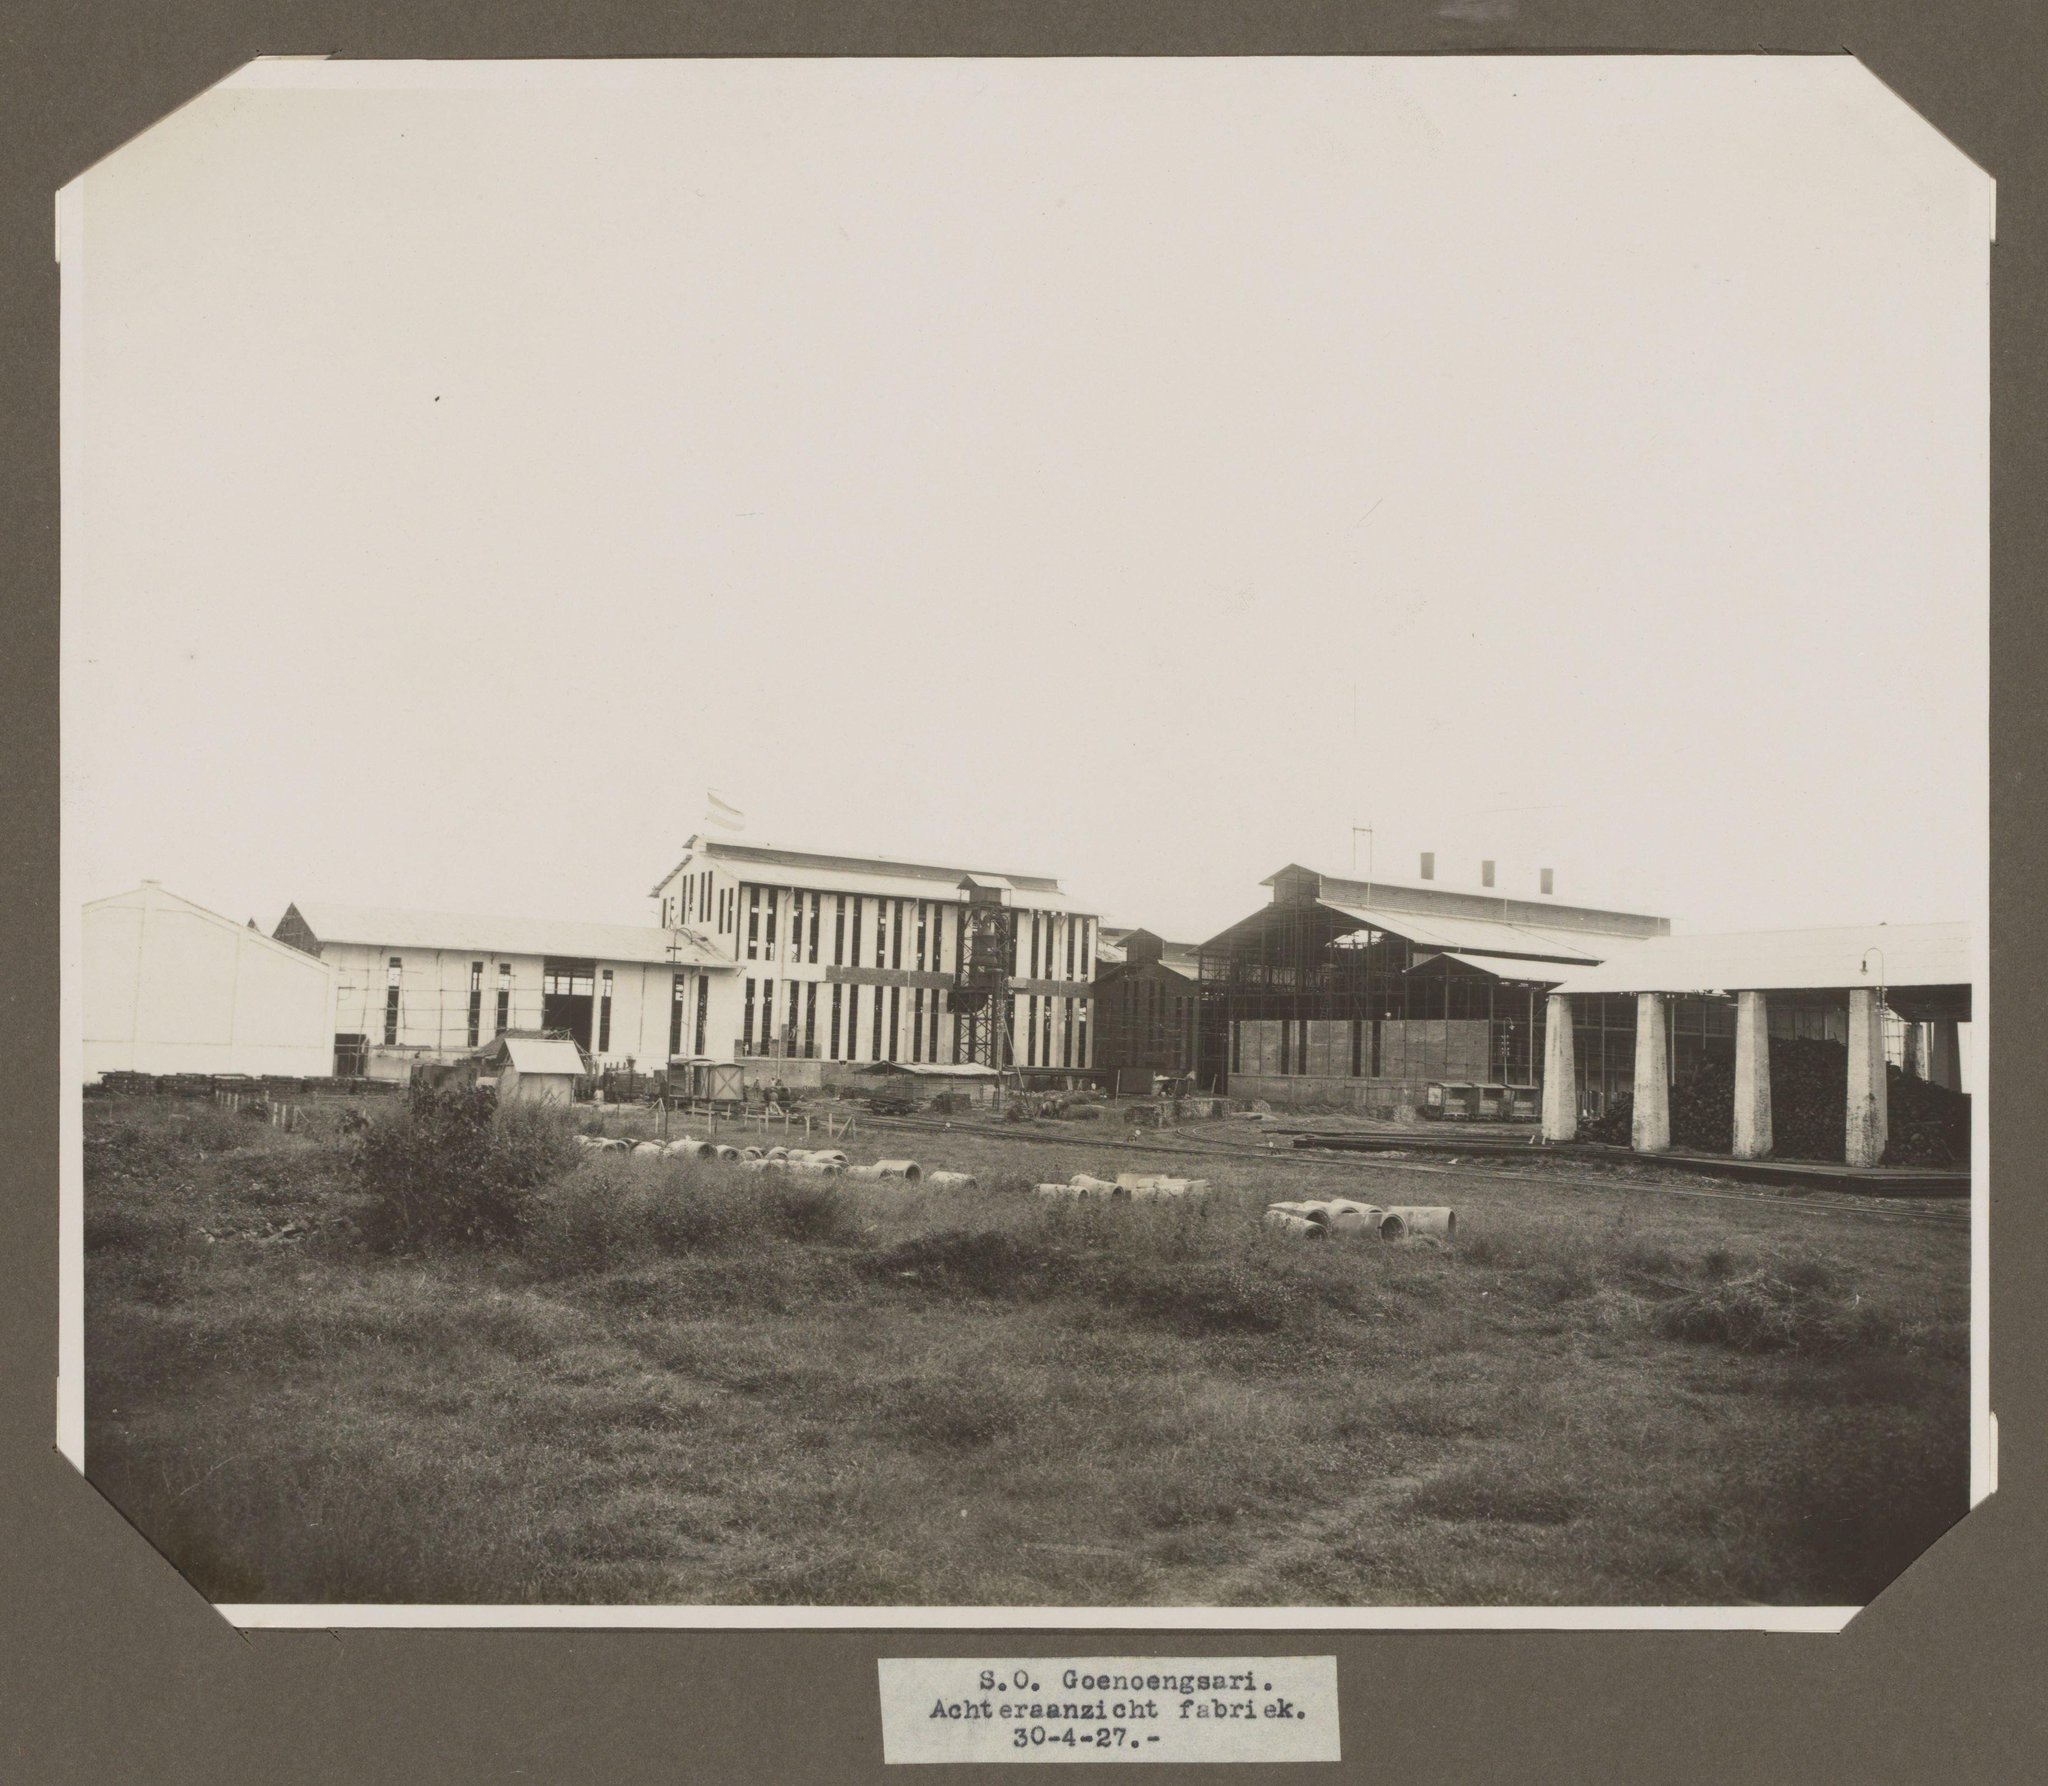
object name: photograph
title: S.O. Goenoengsari. Achteraanzicht fabriek. 30-4-27.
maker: Anonymous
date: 1904-1927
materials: photographic support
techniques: gelatin silver print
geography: east java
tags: colonial system, trade-company, making the overground structures (~ building activities), (non-fruit) products of plants or trees: sugarcane, exterior of industrial structures, factories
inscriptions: inscription: ‘S.O. Goenoengsari. Achteraanzicht fabriek. 30-4-27.’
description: Gezicht op de achterzijde van de fabriek, april 1927. Onderdeel van het fotoalbum met foto's van de opbouw van de suikerfabriek te Goenoengsari op Oost-Java door de Handels Vereniging Amsterdam 1926-1927.